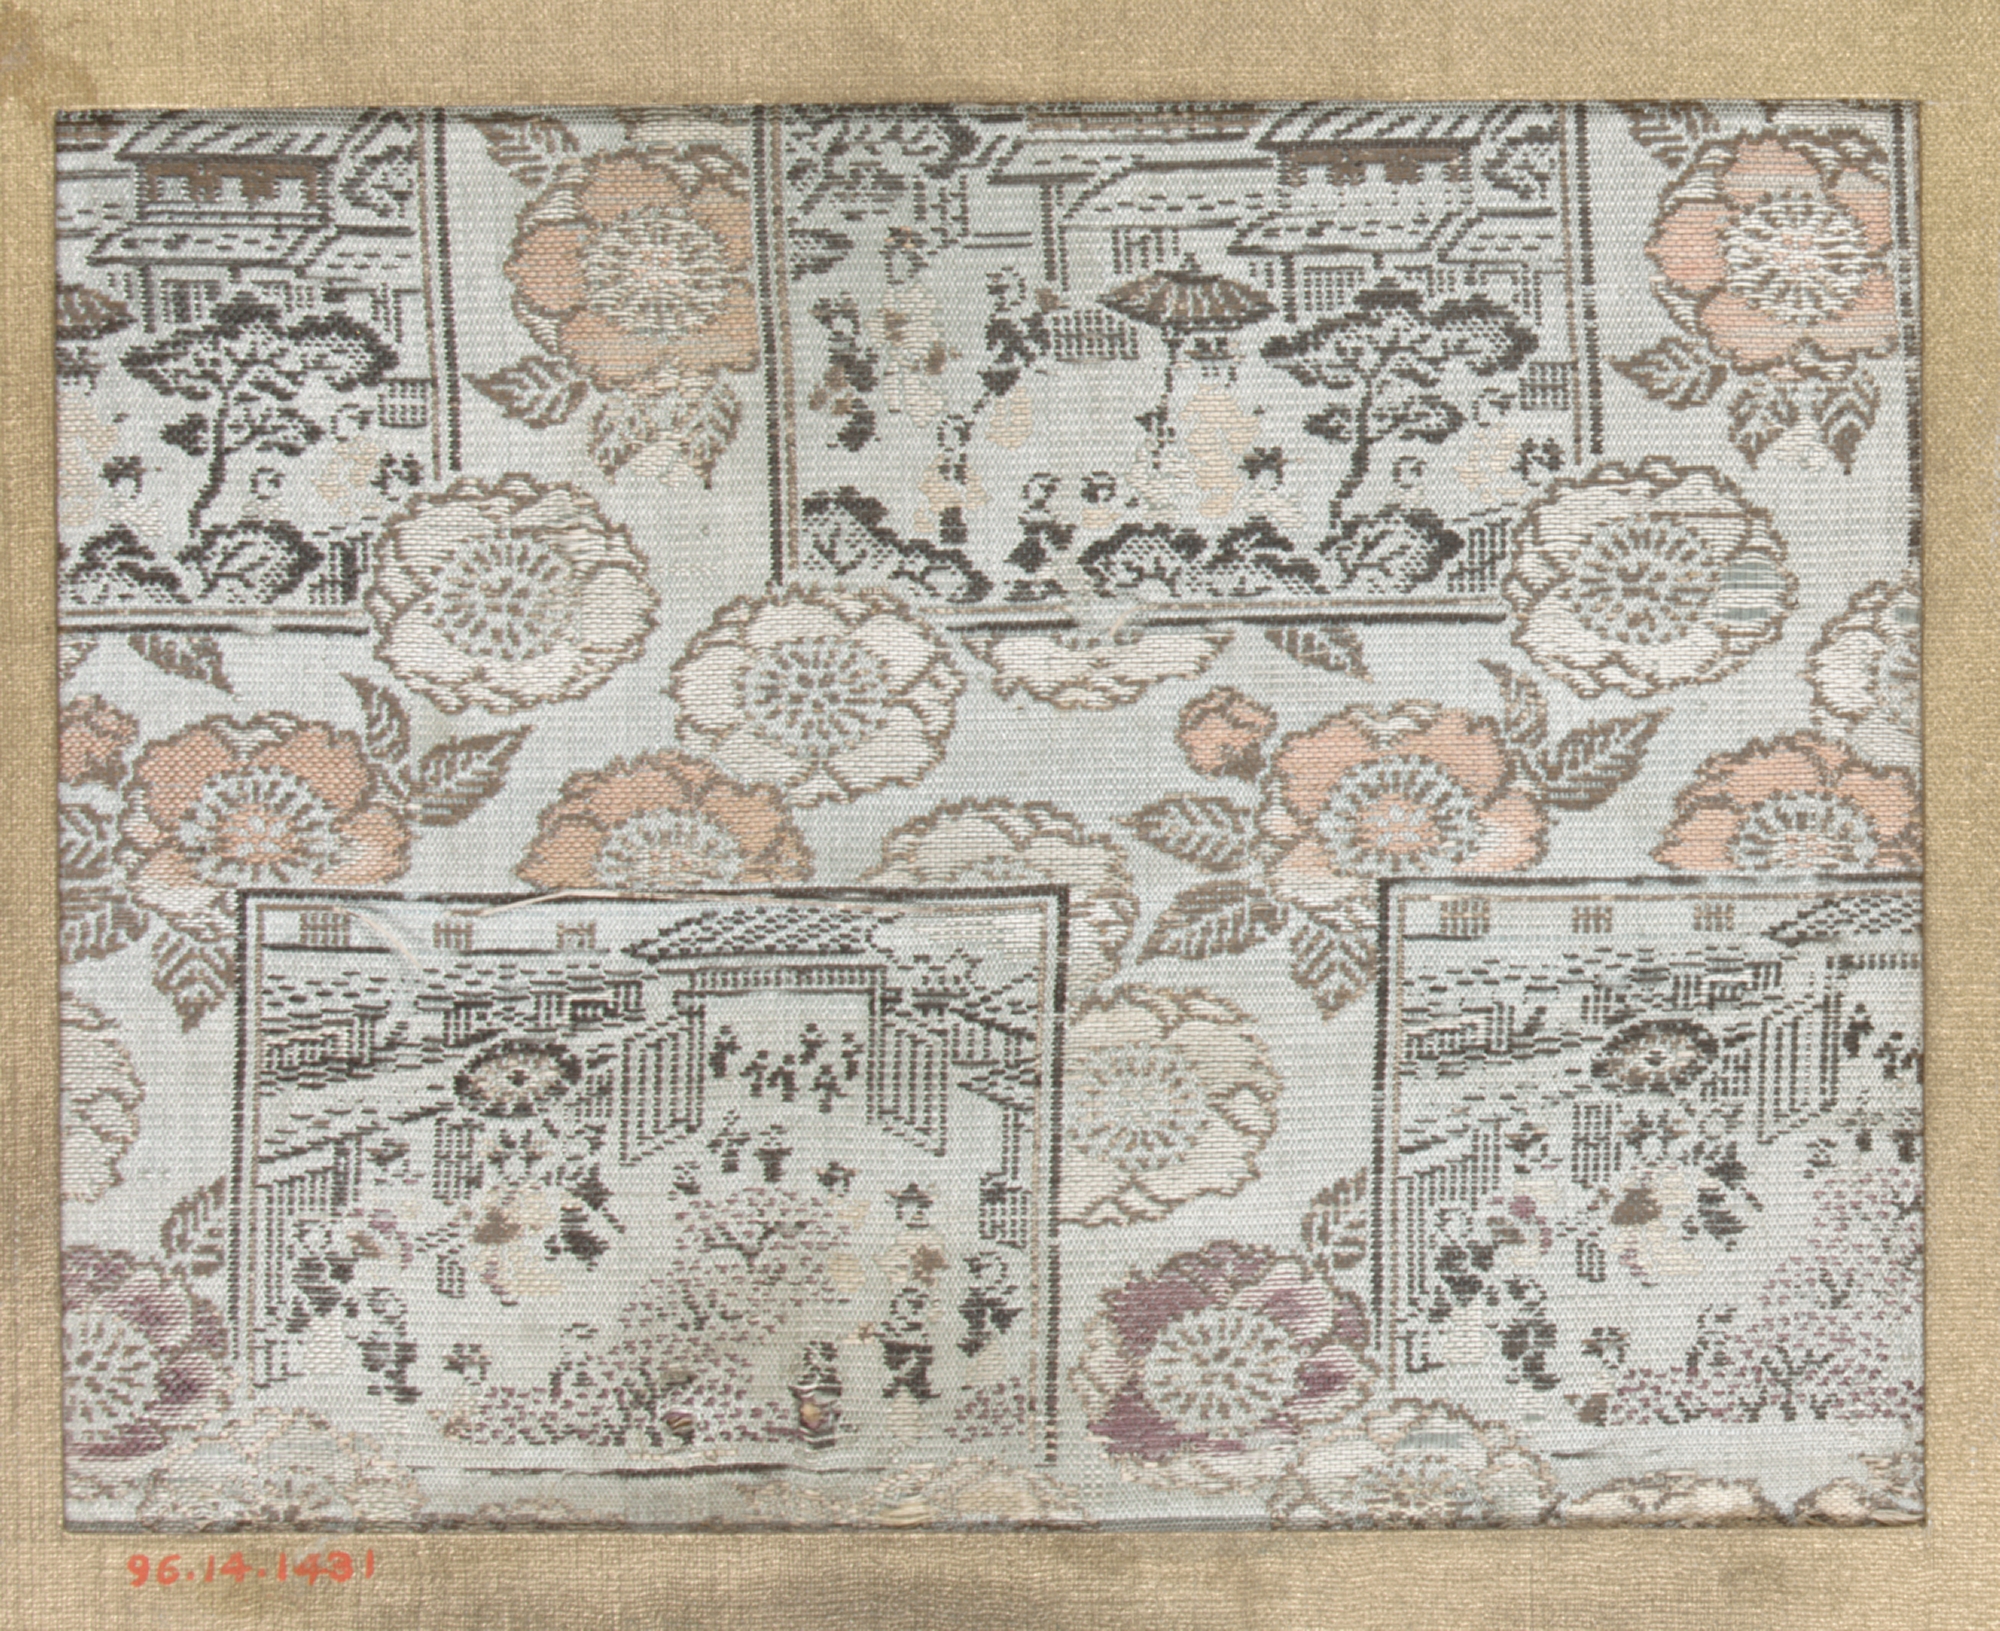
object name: piece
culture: japanese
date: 1701-1900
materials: silk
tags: flowers